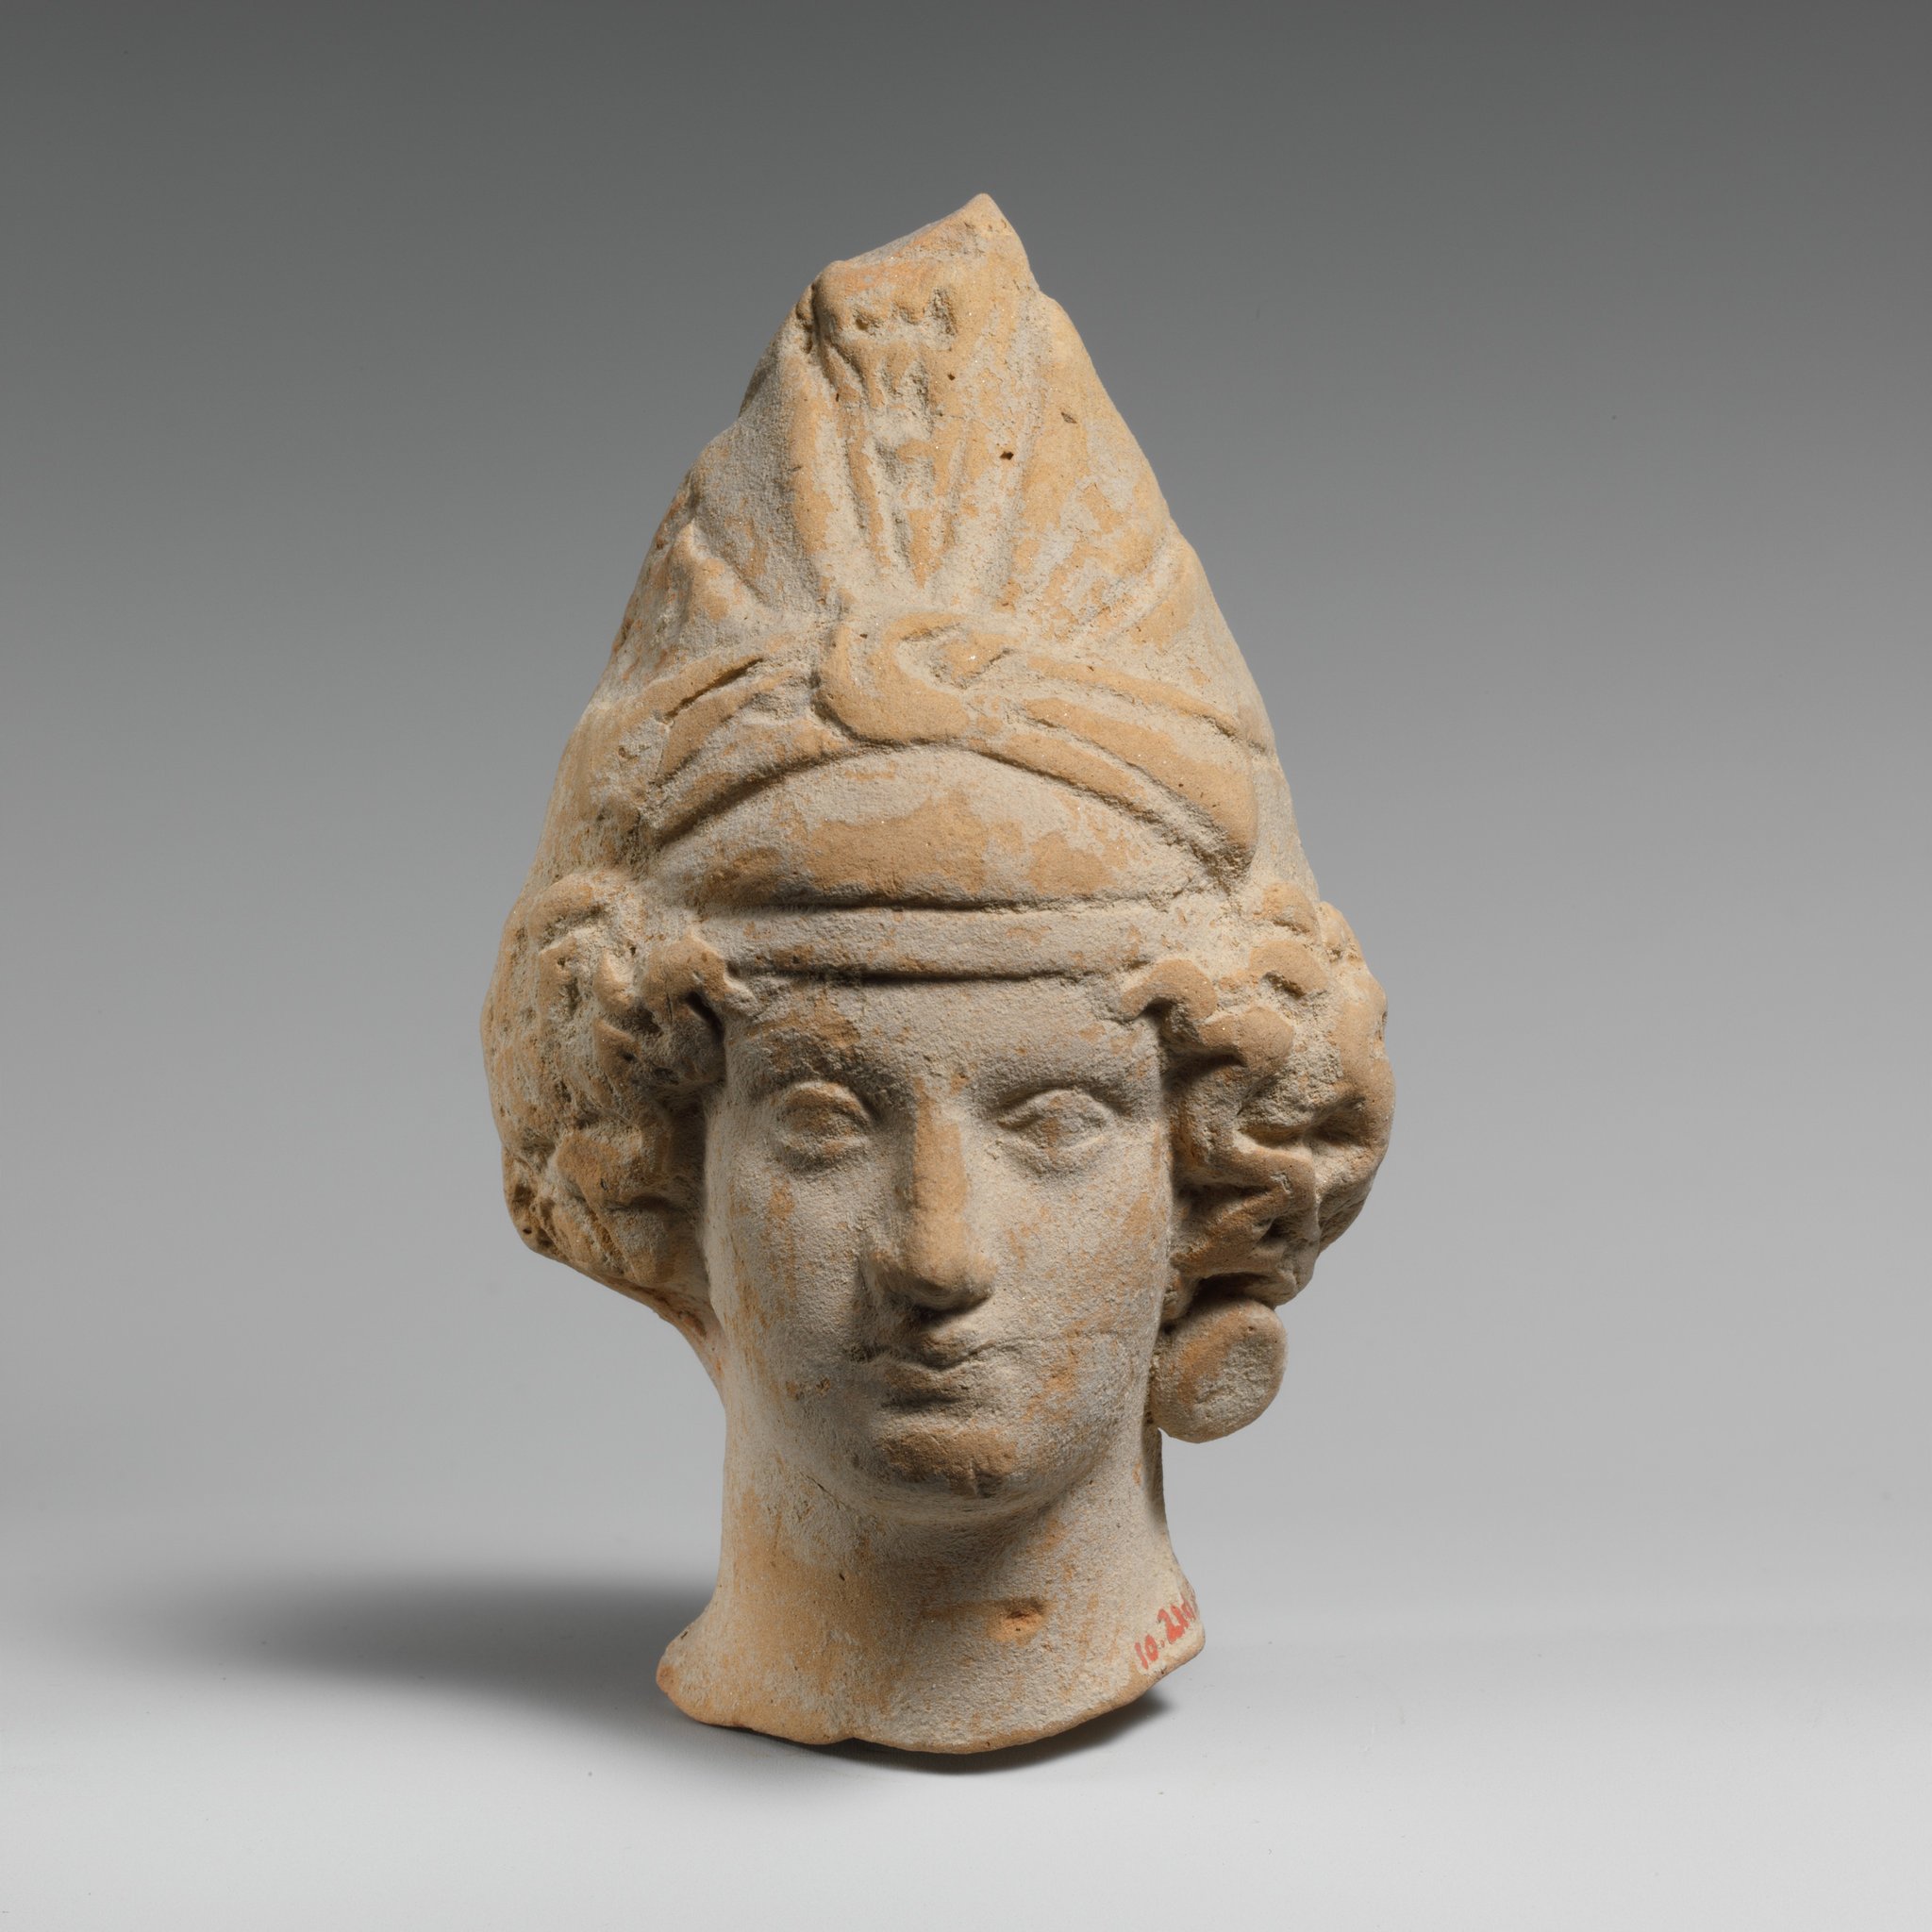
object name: head of a woman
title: Terracotta head of a woman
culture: greek, south italian, tarentine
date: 434-301 BCE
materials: terracotta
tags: heads,women